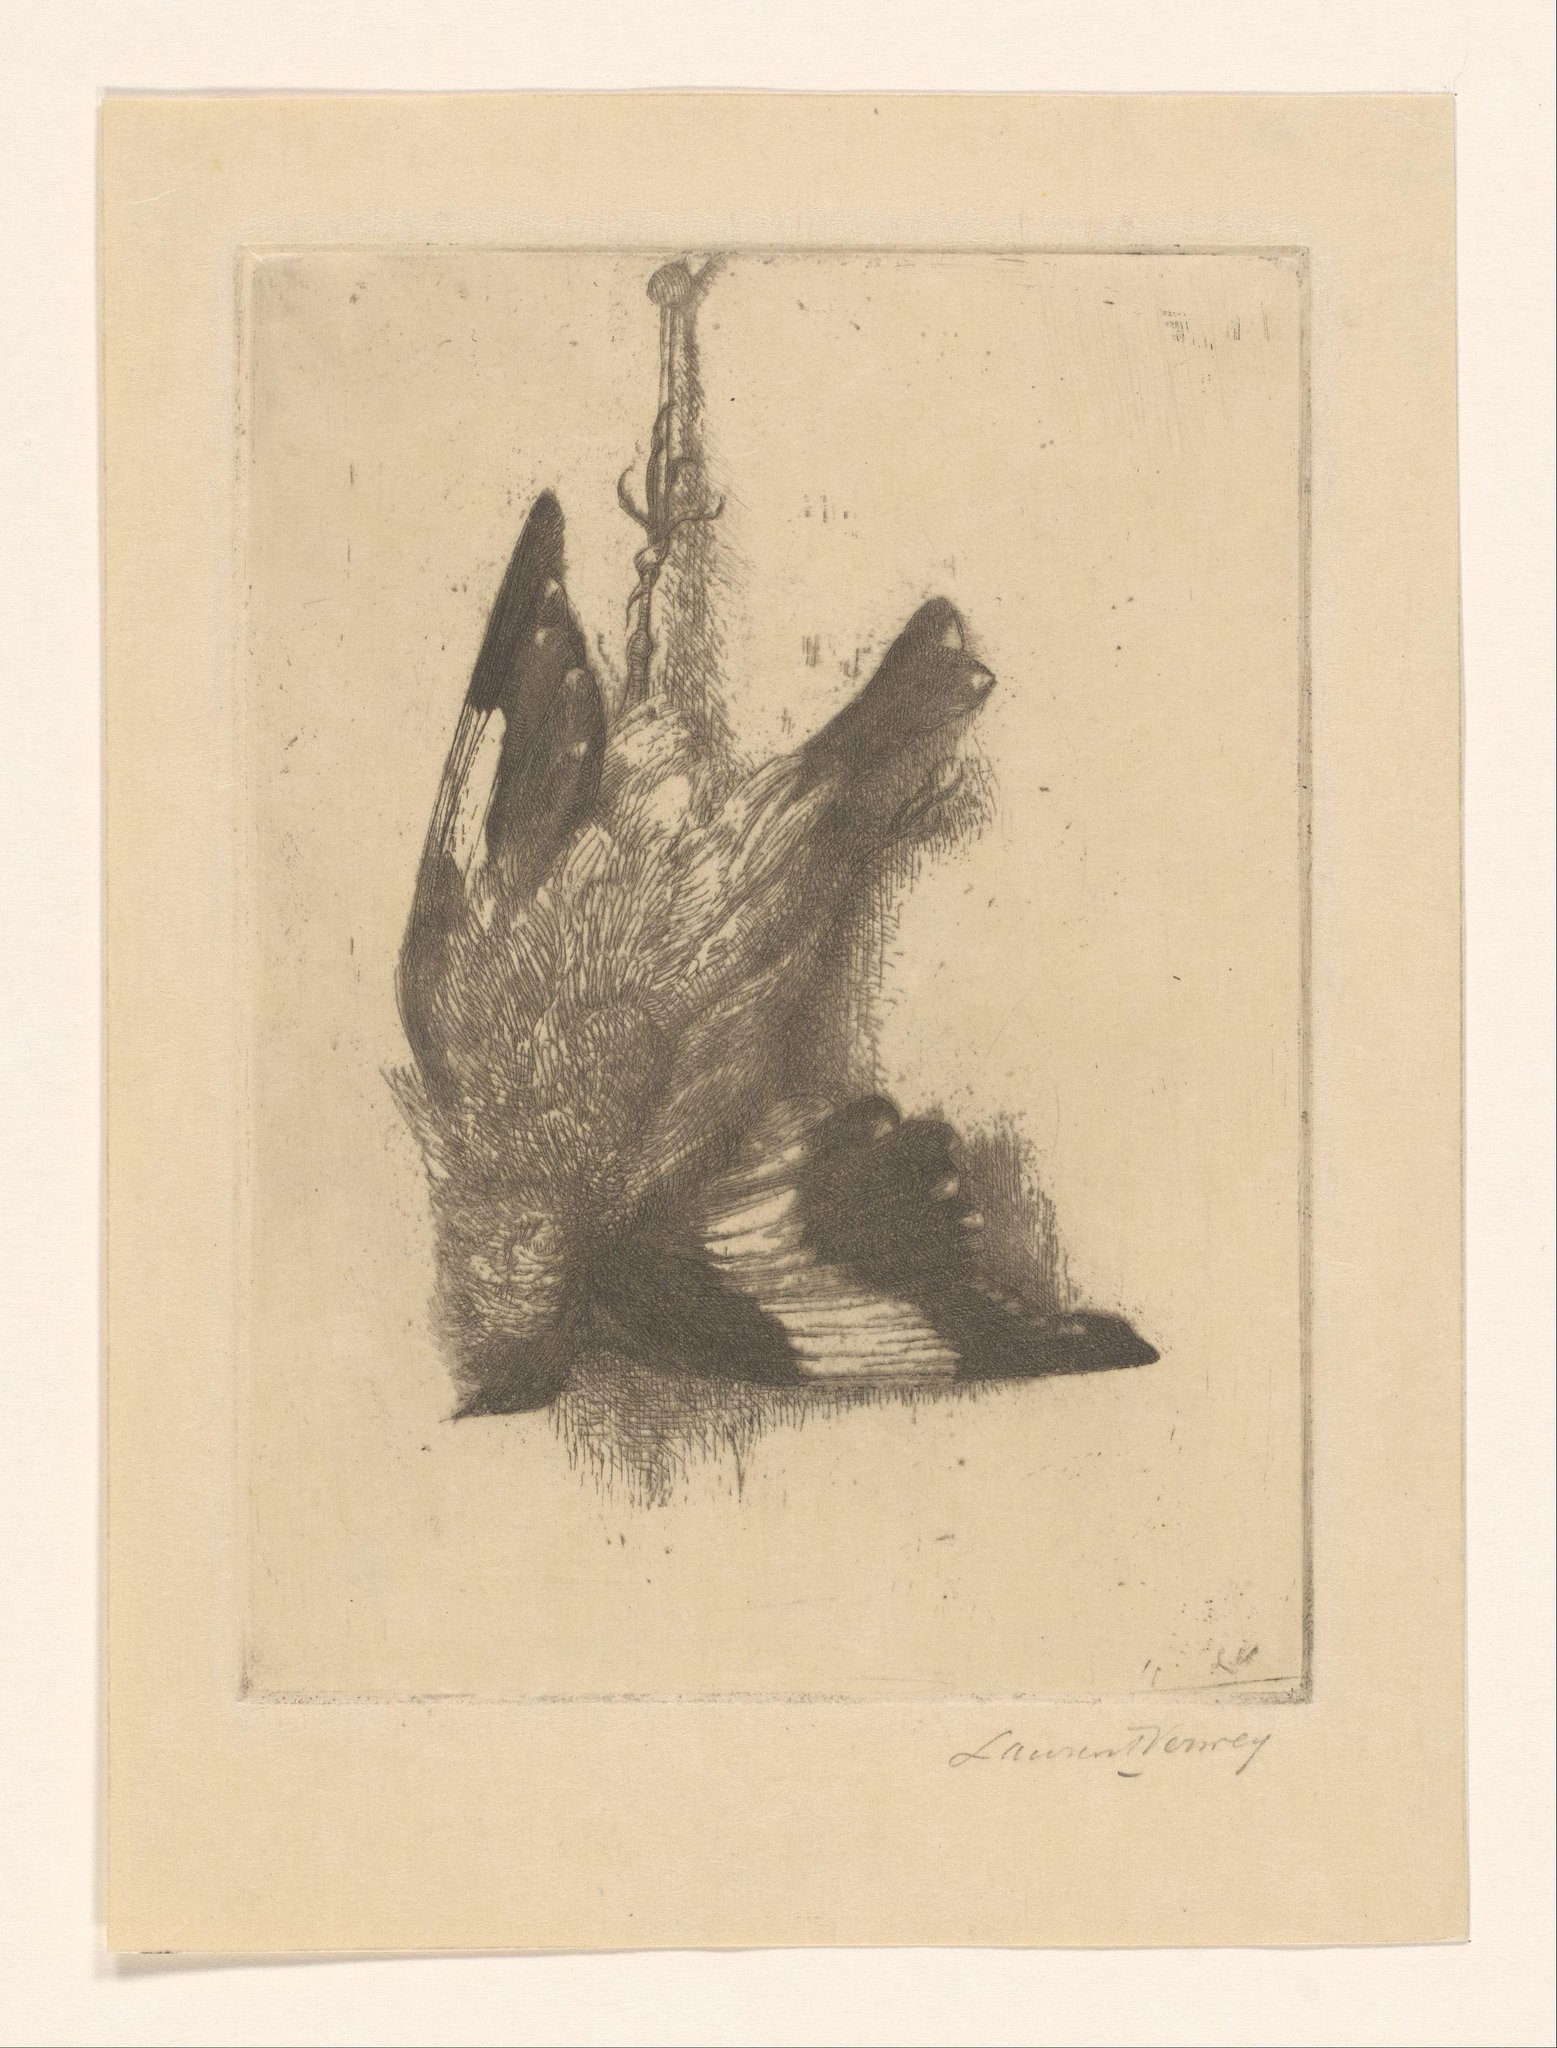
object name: print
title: Dode vogel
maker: laurent verwey van udenhout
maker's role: print maker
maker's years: 1884-1913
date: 1894-1913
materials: paper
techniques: drypoint, etching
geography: netherlands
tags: birds (+ disease and death of animal(s))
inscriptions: collector's mark: Lugt 2760, collector's mark: Lugt 2228